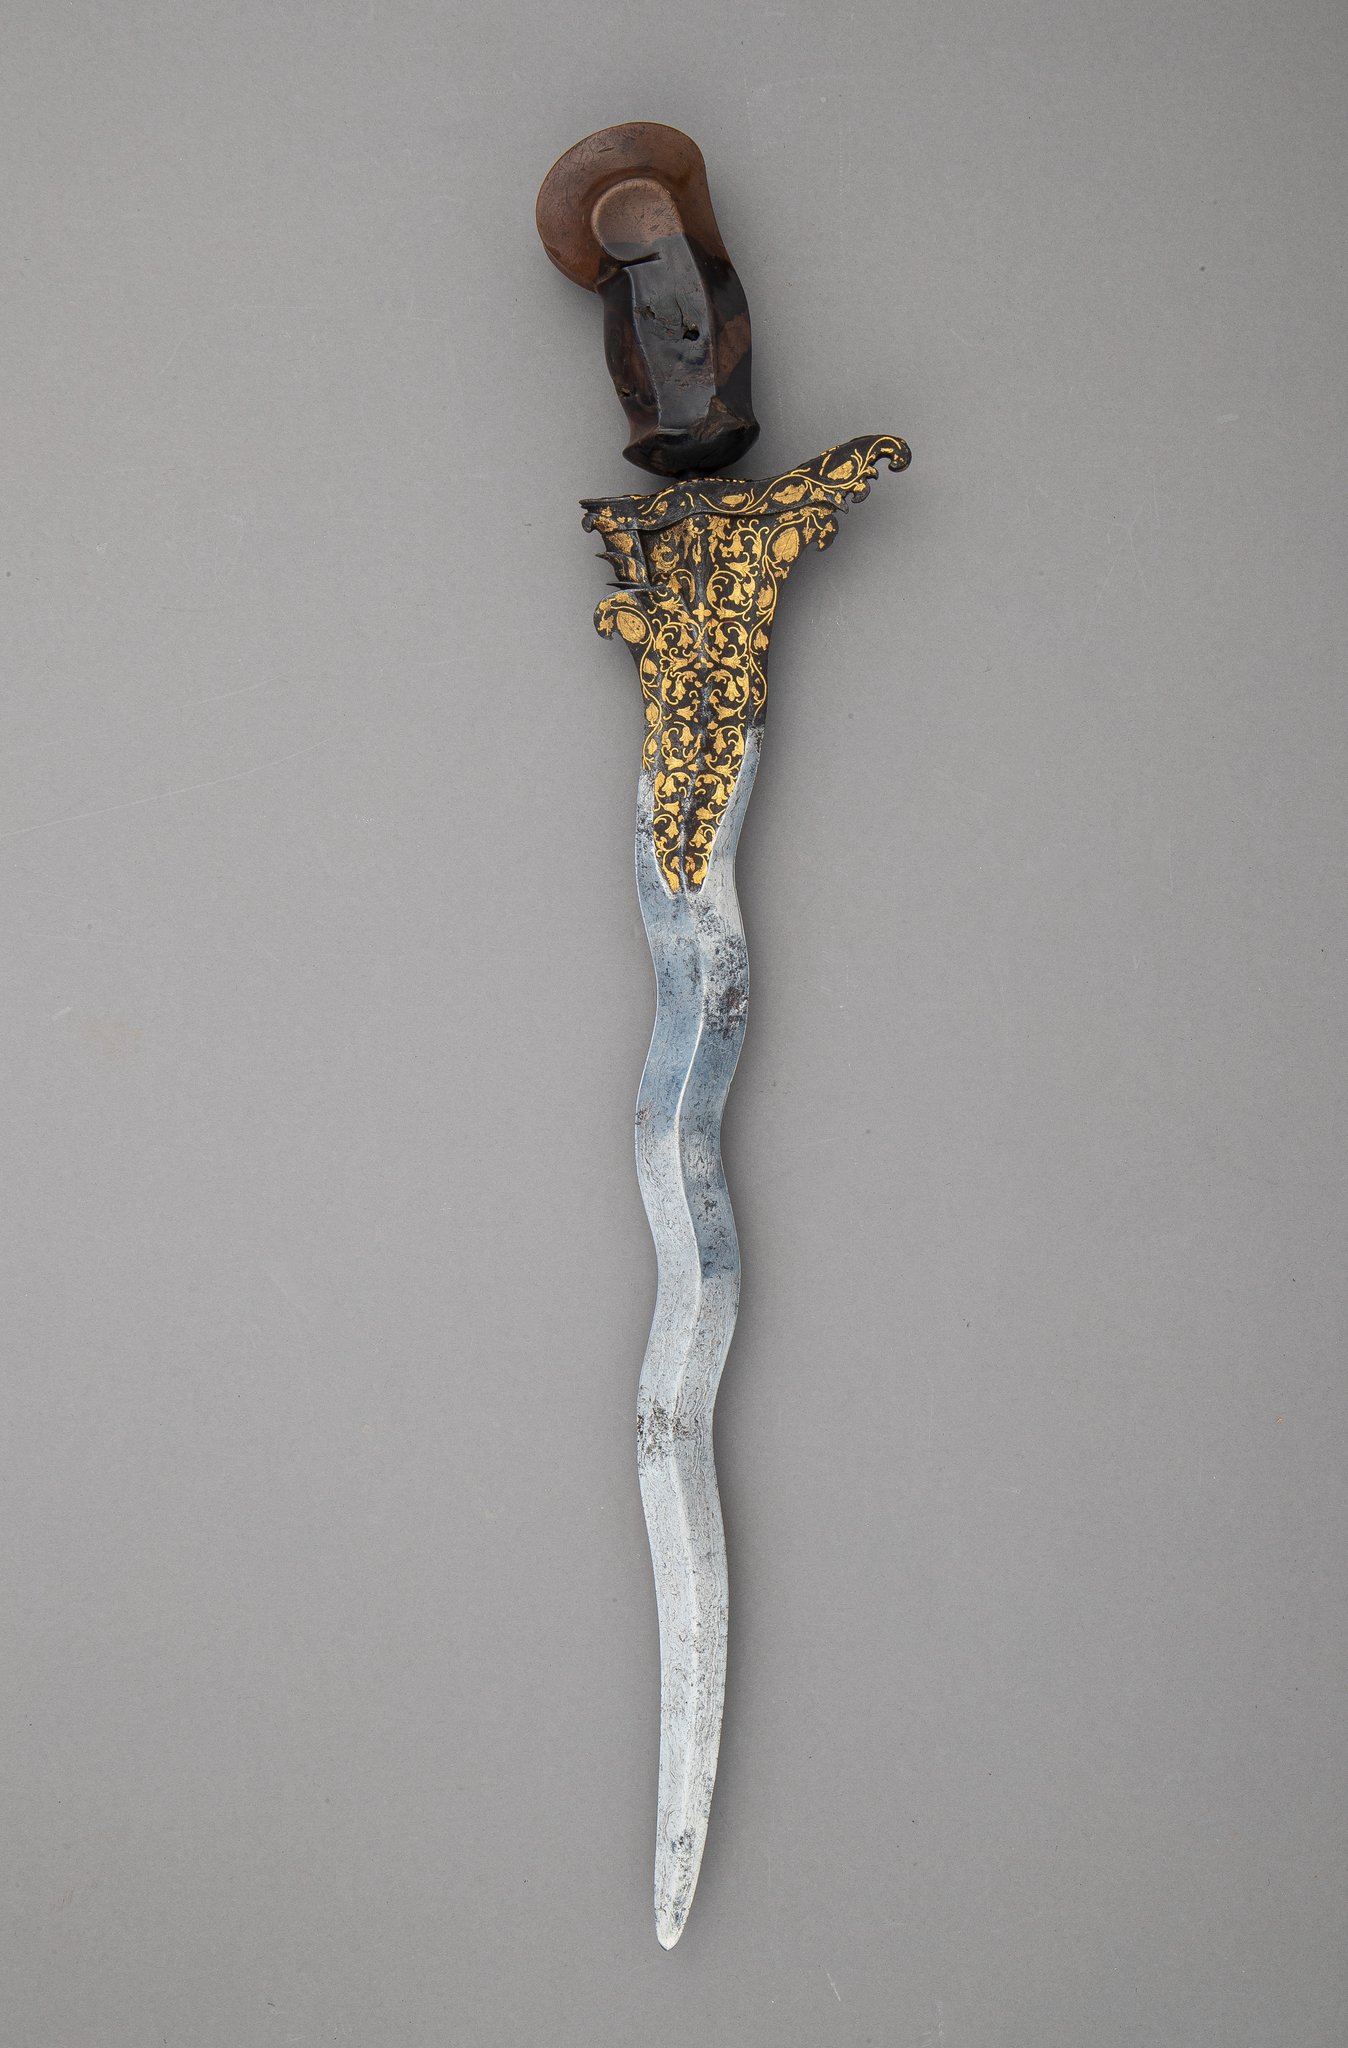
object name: kris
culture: balinese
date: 1501-1900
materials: gold, steel, wood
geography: indonesia